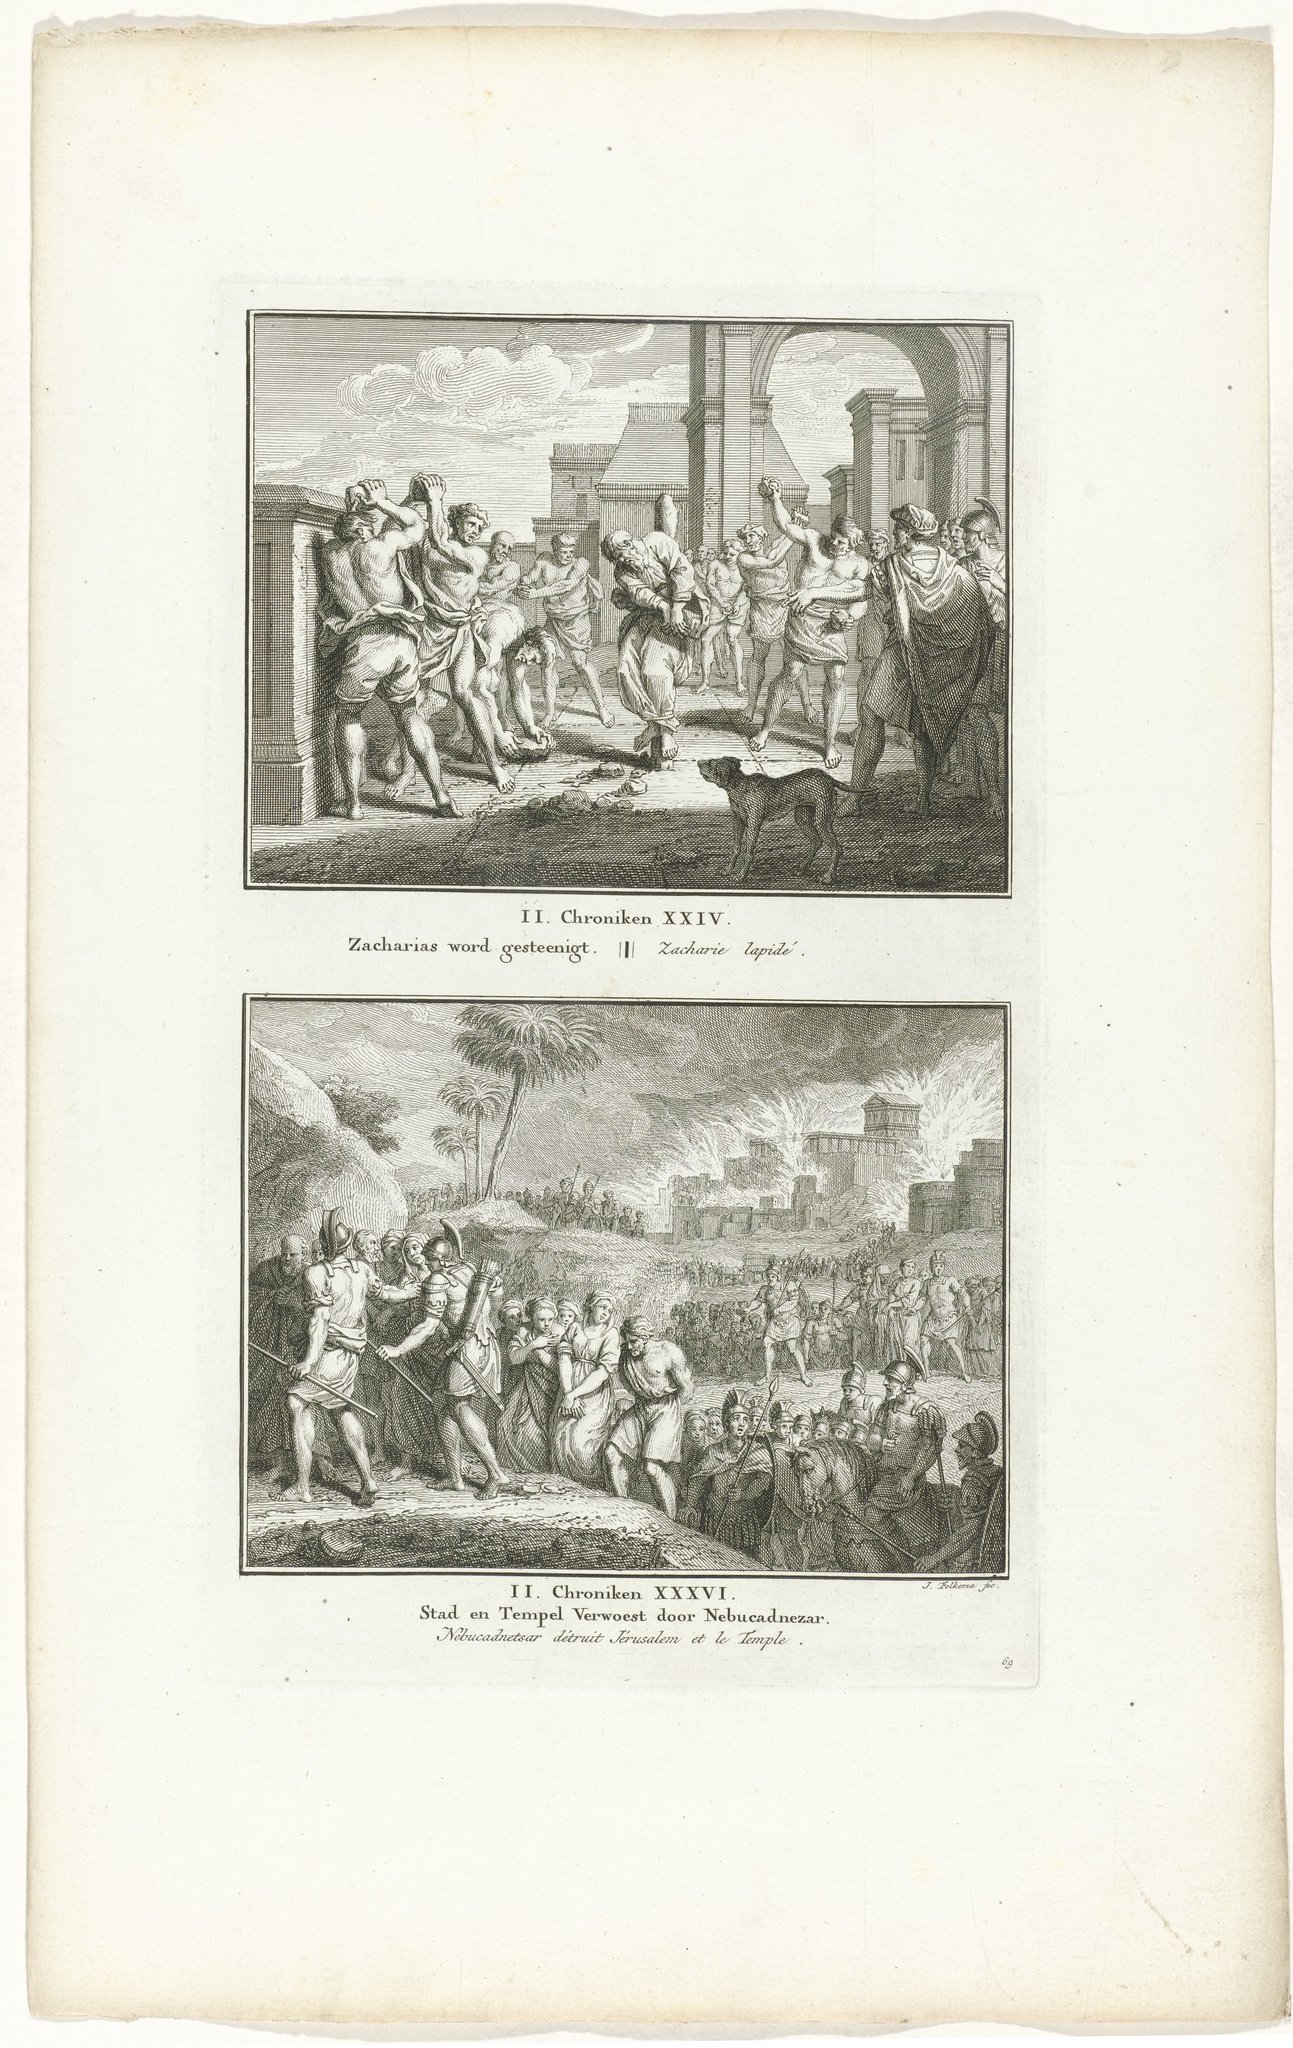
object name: book illustration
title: Zacharia wordt gestenigd en Nebukadnézar verwoest Jeruzalem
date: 1791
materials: paper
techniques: etching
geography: amsterdam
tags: nebuchadnezzar captures the city; jehoiachin, his mother, his wives, and the royal princes are carried away as prisoners (first siege of jerusalem, at the king's order the people stone zechariah in the temple courtyard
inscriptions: collector's mark: Lugt 2233, collector's mark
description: Twee Bijbelse voorstellingen uit 2 Kron. 24 en 36. Zacharia wordt gestenigd in opdracht van de koning, en Nebukadnézar verwoest Jeruzalem. Twee voorstellingen van één plaat, elk voorzien van een titel in het Nederlands en Frans. Geheel rechtsonder genummerd: 69.